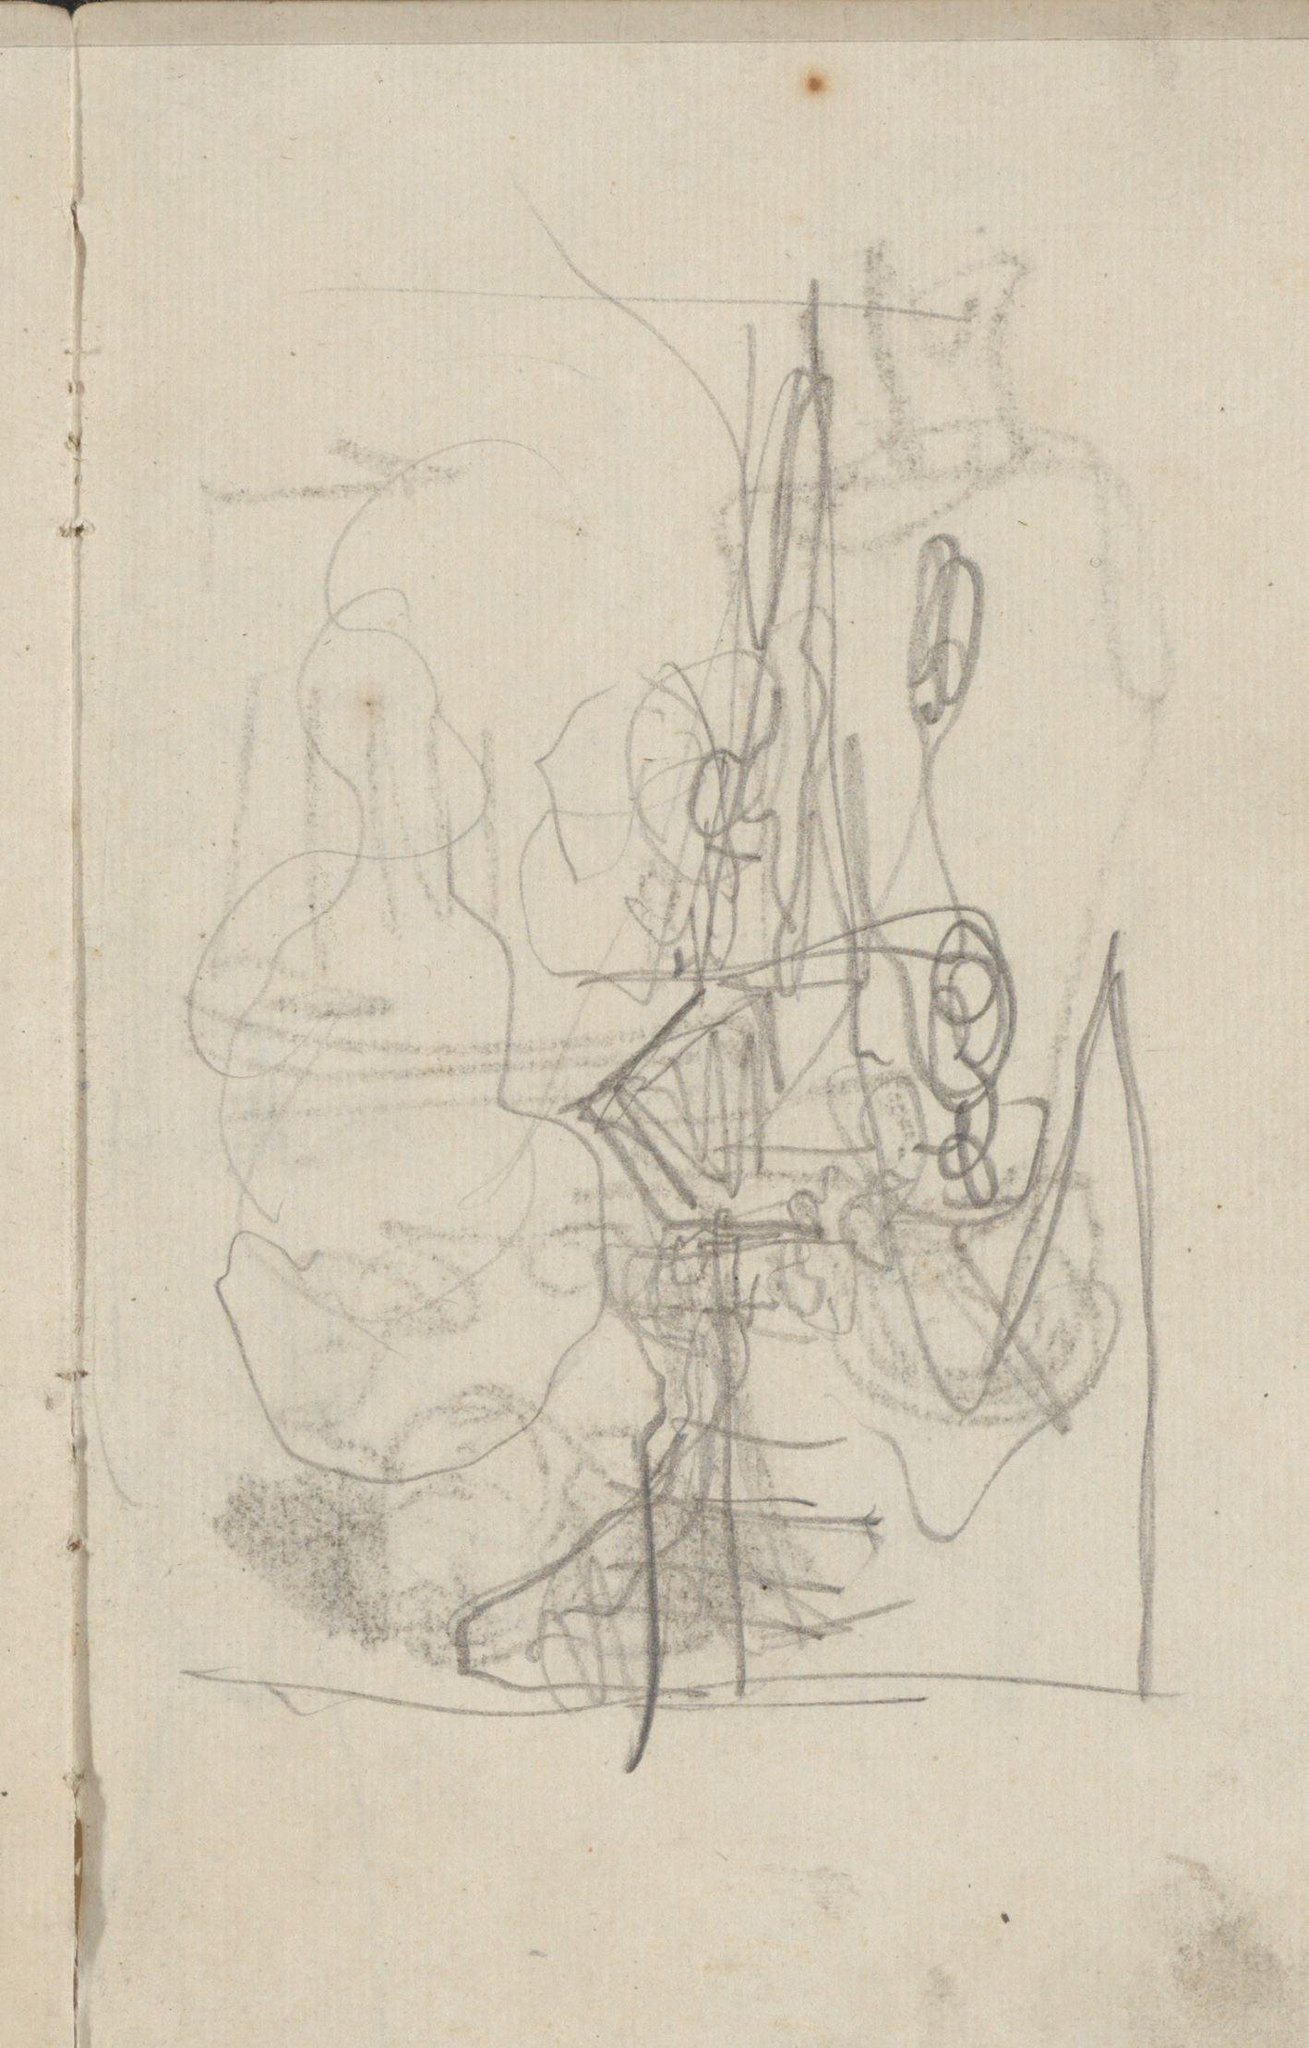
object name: sketchbook leaf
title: Studie, mogelijk van een landschap met bebouwing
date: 1881-1883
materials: paper, pencil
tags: landscapes, civic architecture; edifices; dwellings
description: Pagina 15 uit een schetsboek met 29 bladen.